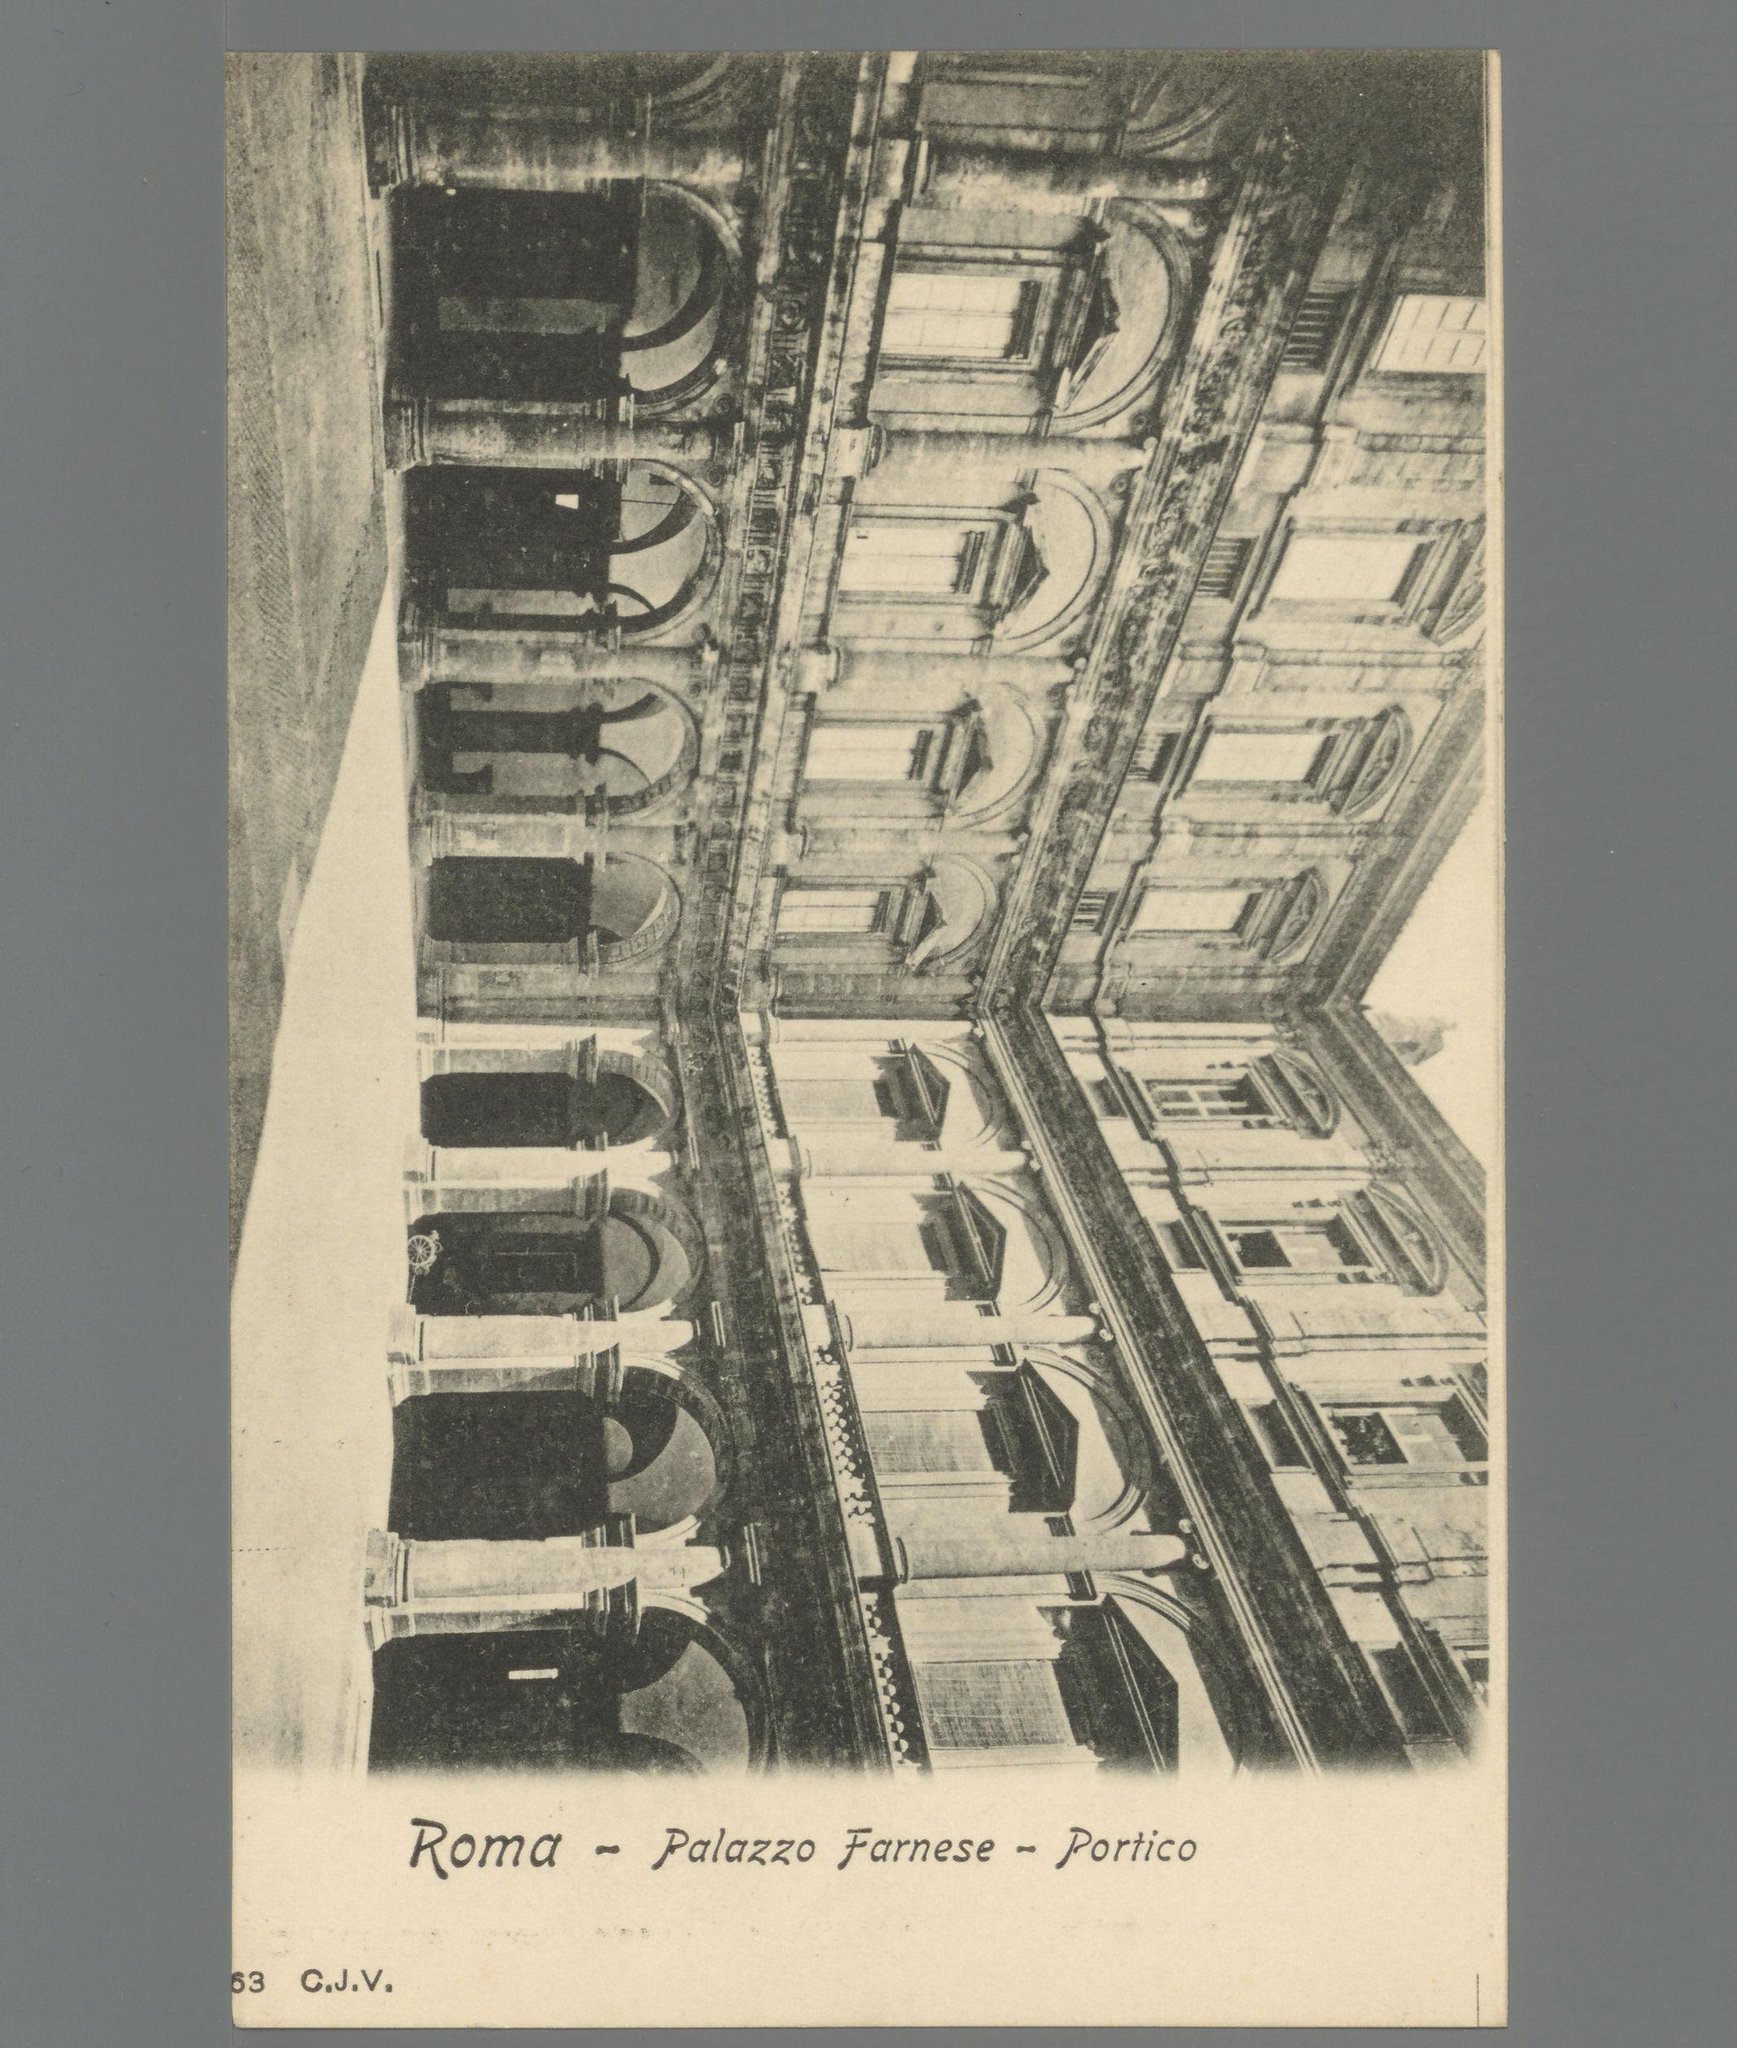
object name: photomechanical print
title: Roma. Palazzo Farnese. Portico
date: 1889-1906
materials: cardboard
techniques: photograph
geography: rome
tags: arcade ~ architecture, inner court of palace or 'hôtel'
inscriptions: monogram: ‘C.J.V.’